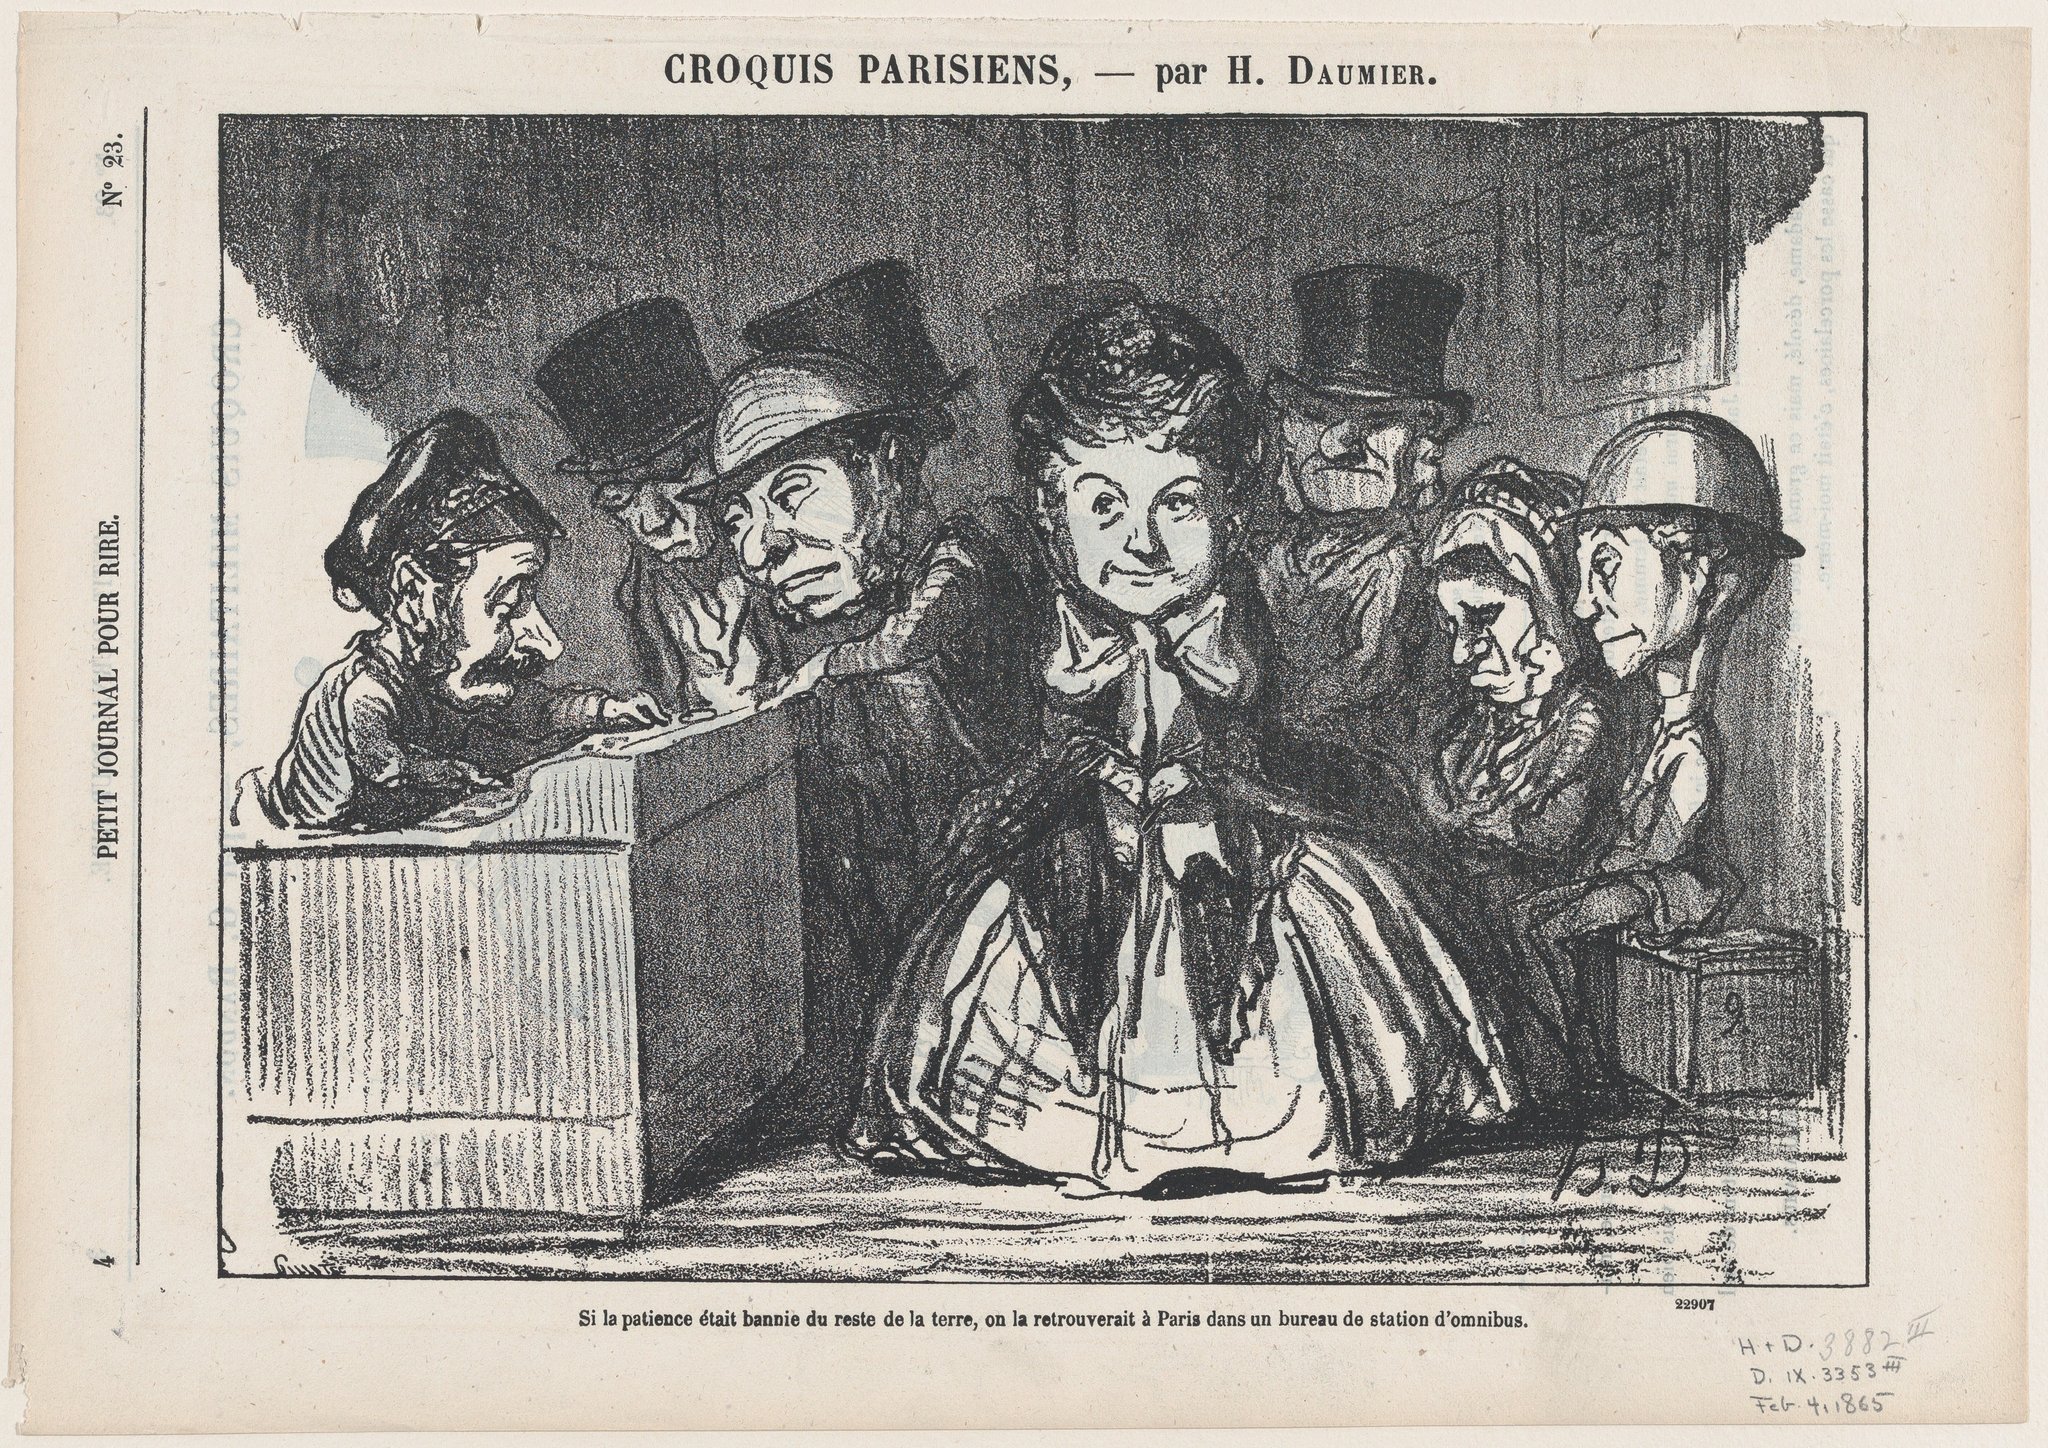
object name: print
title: If patience had disappeared all over the world, one would surely find it again at a bus station in Paris, from "Parisian Sketches"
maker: honoré daumier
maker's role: artist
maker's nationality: french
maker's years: 1808-1879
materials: paper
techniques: lithograph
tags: satire,men,women